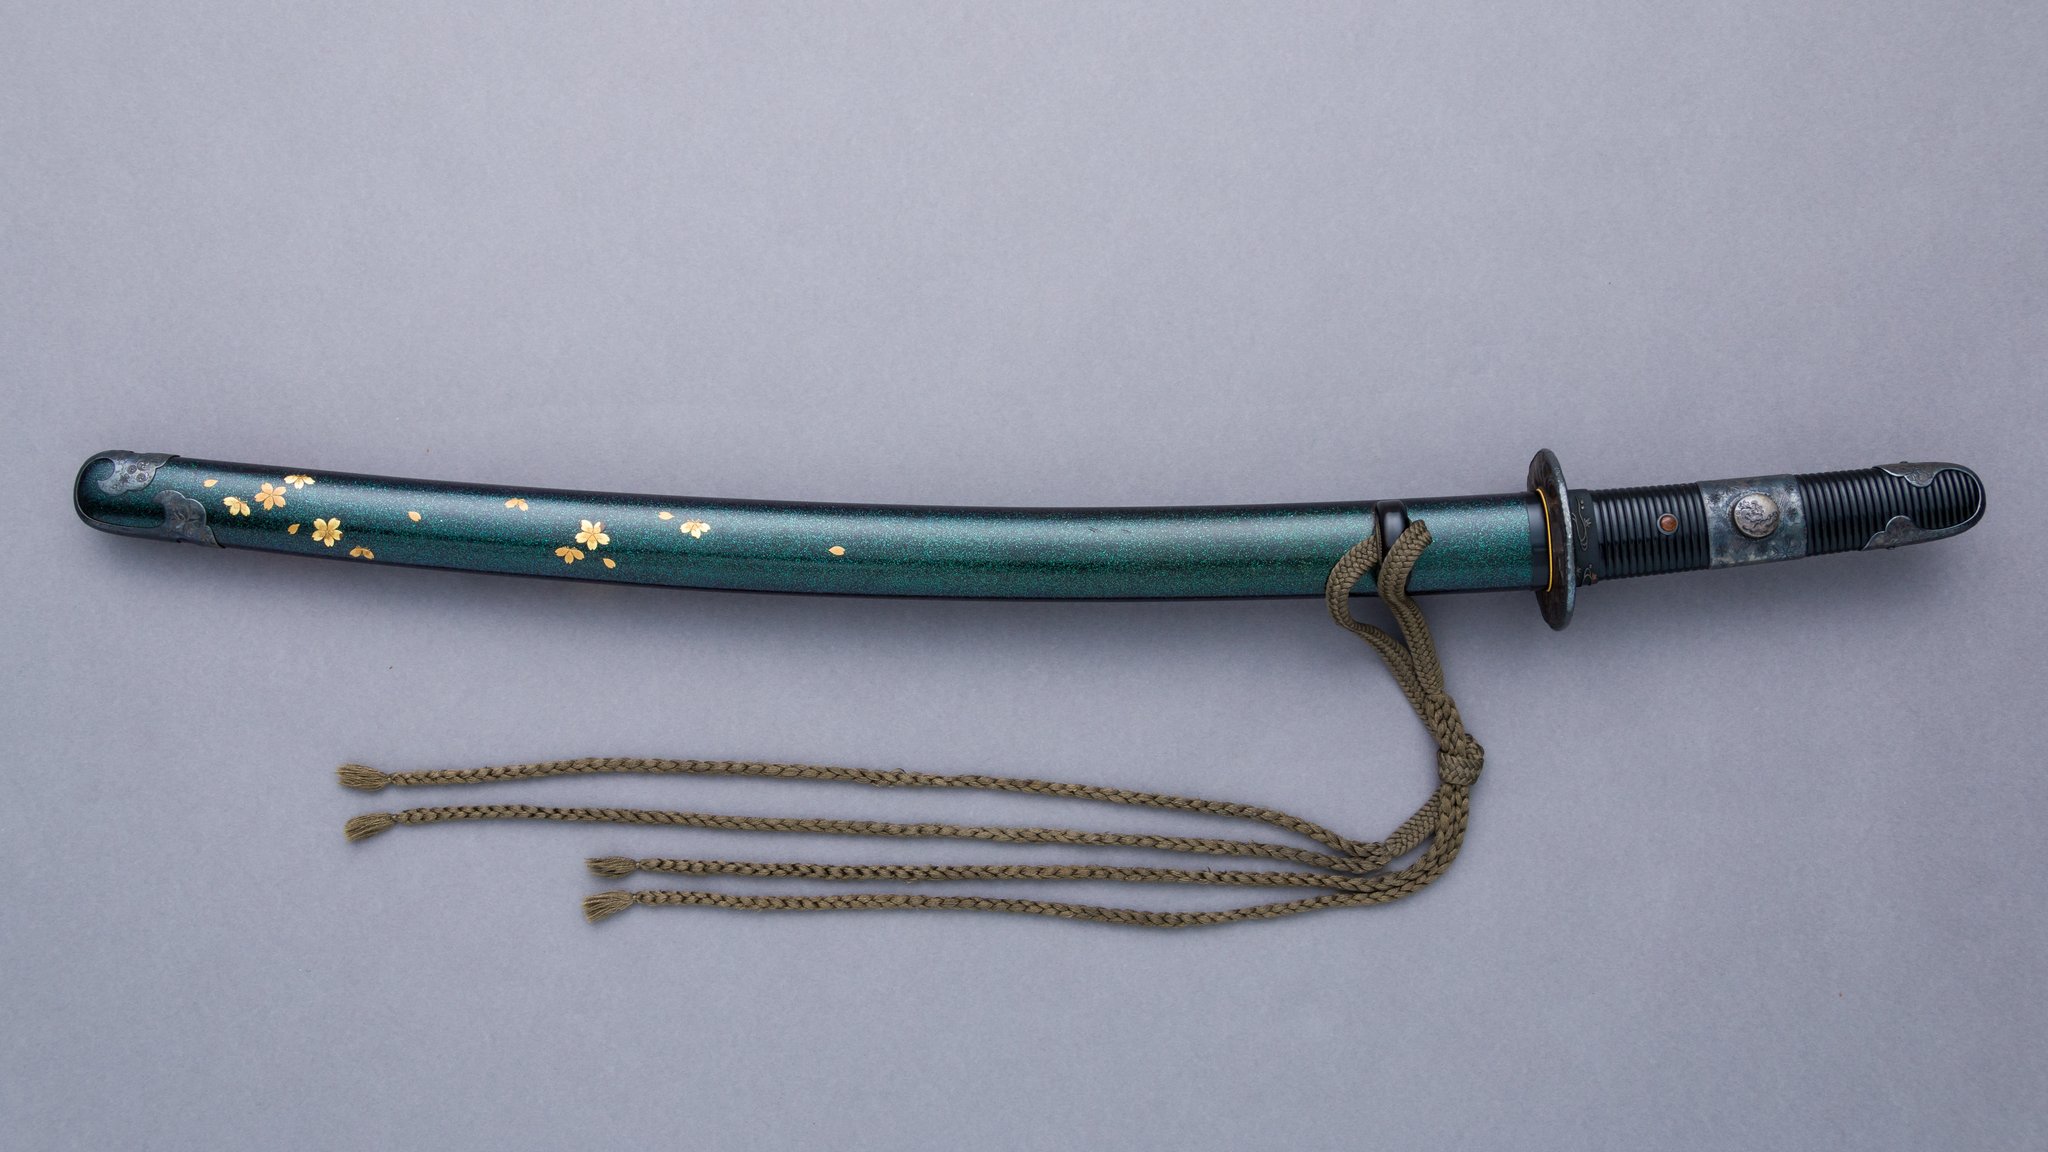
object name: blade and mounting for a short sword wakizashi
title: Blade and Mounting for a Short Sword (Wakizashi)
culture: japanese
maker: kawachino kamifujiwara rai[...]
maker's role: swordsmith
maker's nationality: japanese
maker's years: 1701-1800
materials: copper, gold alloy, gold, iron, lacquer, shell, silk, silver, steel, wood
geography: japan